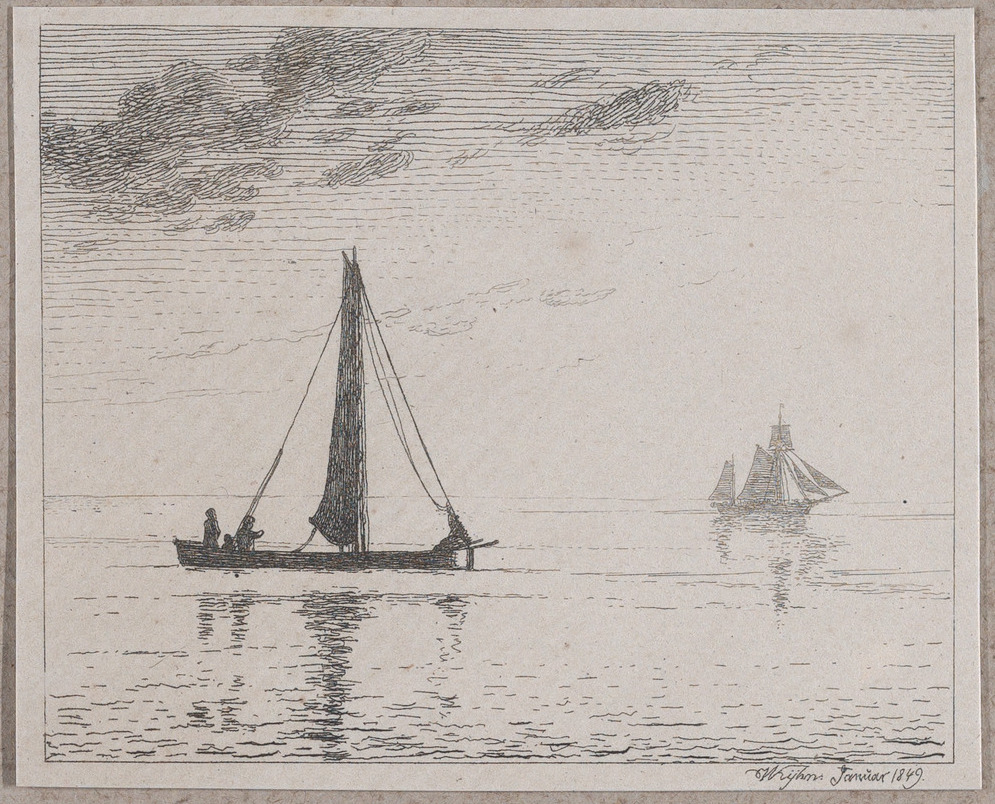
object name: print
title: Maritime View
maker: peter vilhelm carl kyhn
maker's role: artist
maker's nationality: danish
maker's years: 1819-1903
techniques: etching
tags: boats